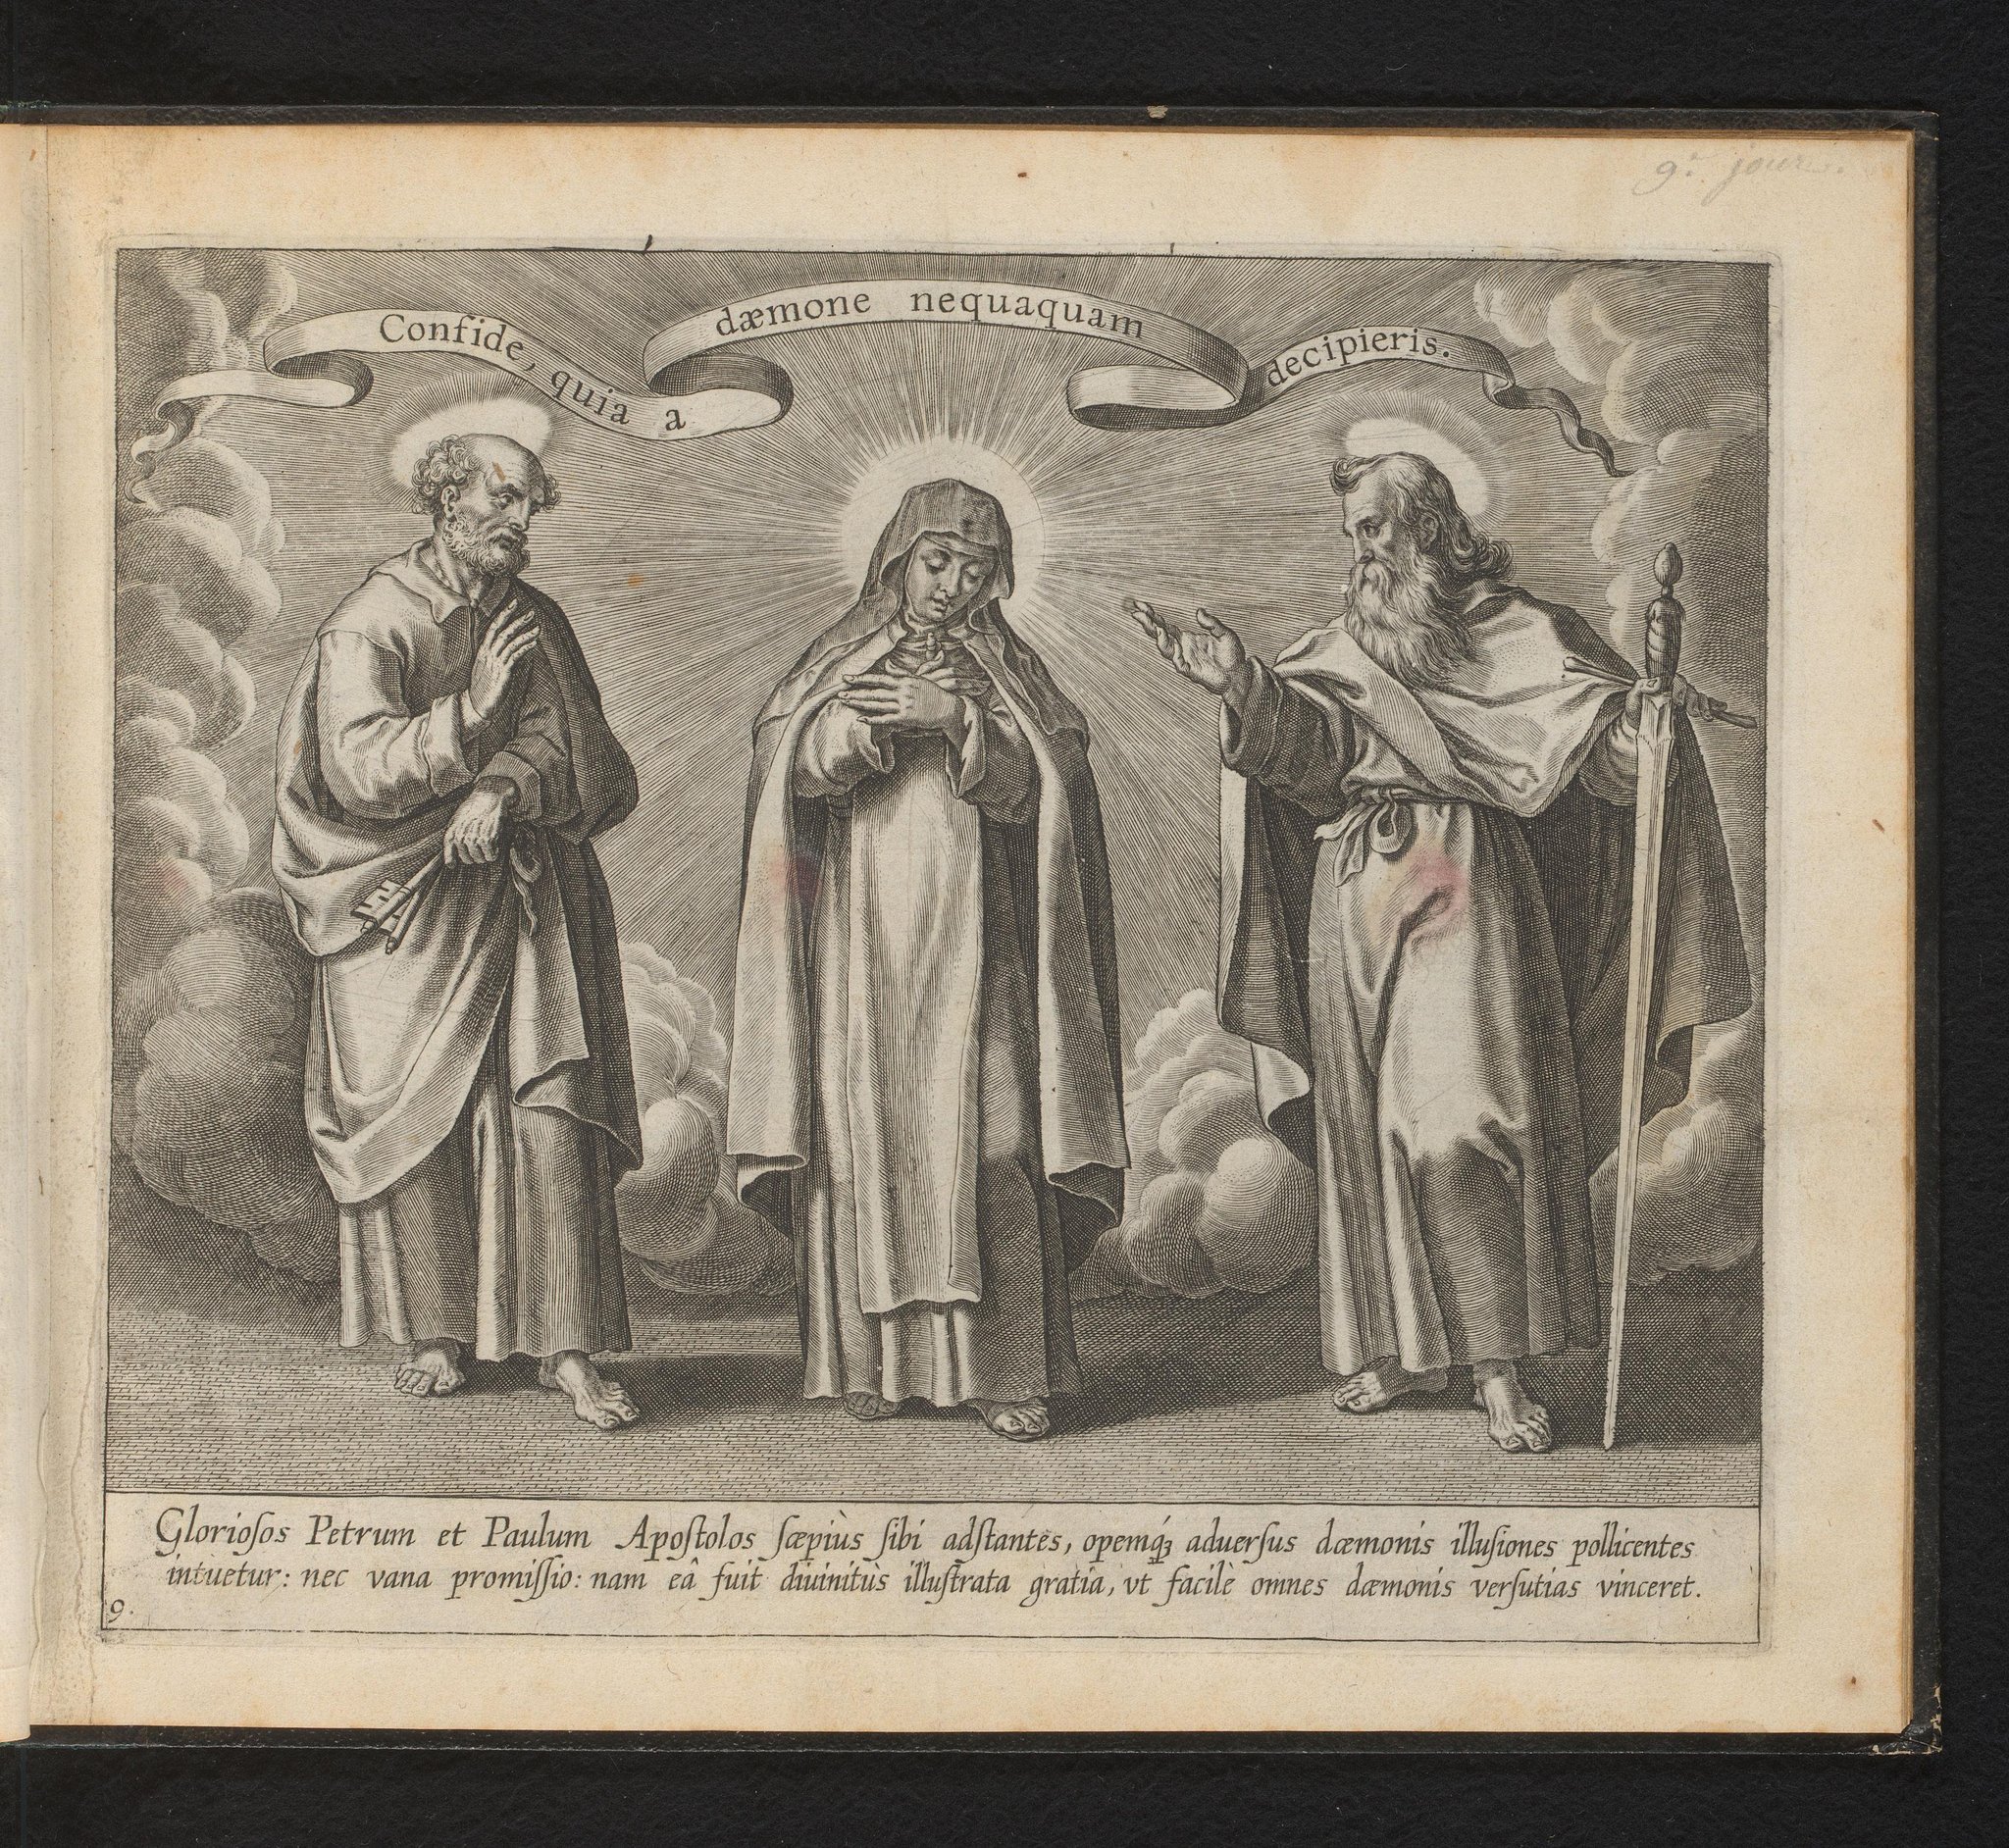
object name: print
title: De H. Petrus en Paulus staan Theresa vaak ter zijde bij het overwinnen van demonen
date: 1613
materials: paper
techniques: engraving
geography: antwerp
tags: the foundress of the reformed (discalced) carmelites, t(h)eres(i)a of avila; possible attributes: angel, arrow, dove, heart (flaming or pierced by an arrow), the apostle peter, first bishop of rome; possible attributes: book, cock, (upturned) cross, (triple) crozier, fish, key, scroll, ship, tiara, the apostle paul of tarsus; possible attributes: book, scroll, sword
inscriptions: caption: ‘Gloriosos Petrum et Paulum...versutias vinceret.’, number: ‘9’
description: Prent in album 'Vita B. Virginis Teresiae A. Jesu ordinis carmelitarum excalceatorum piae restauratricis..., 1613.